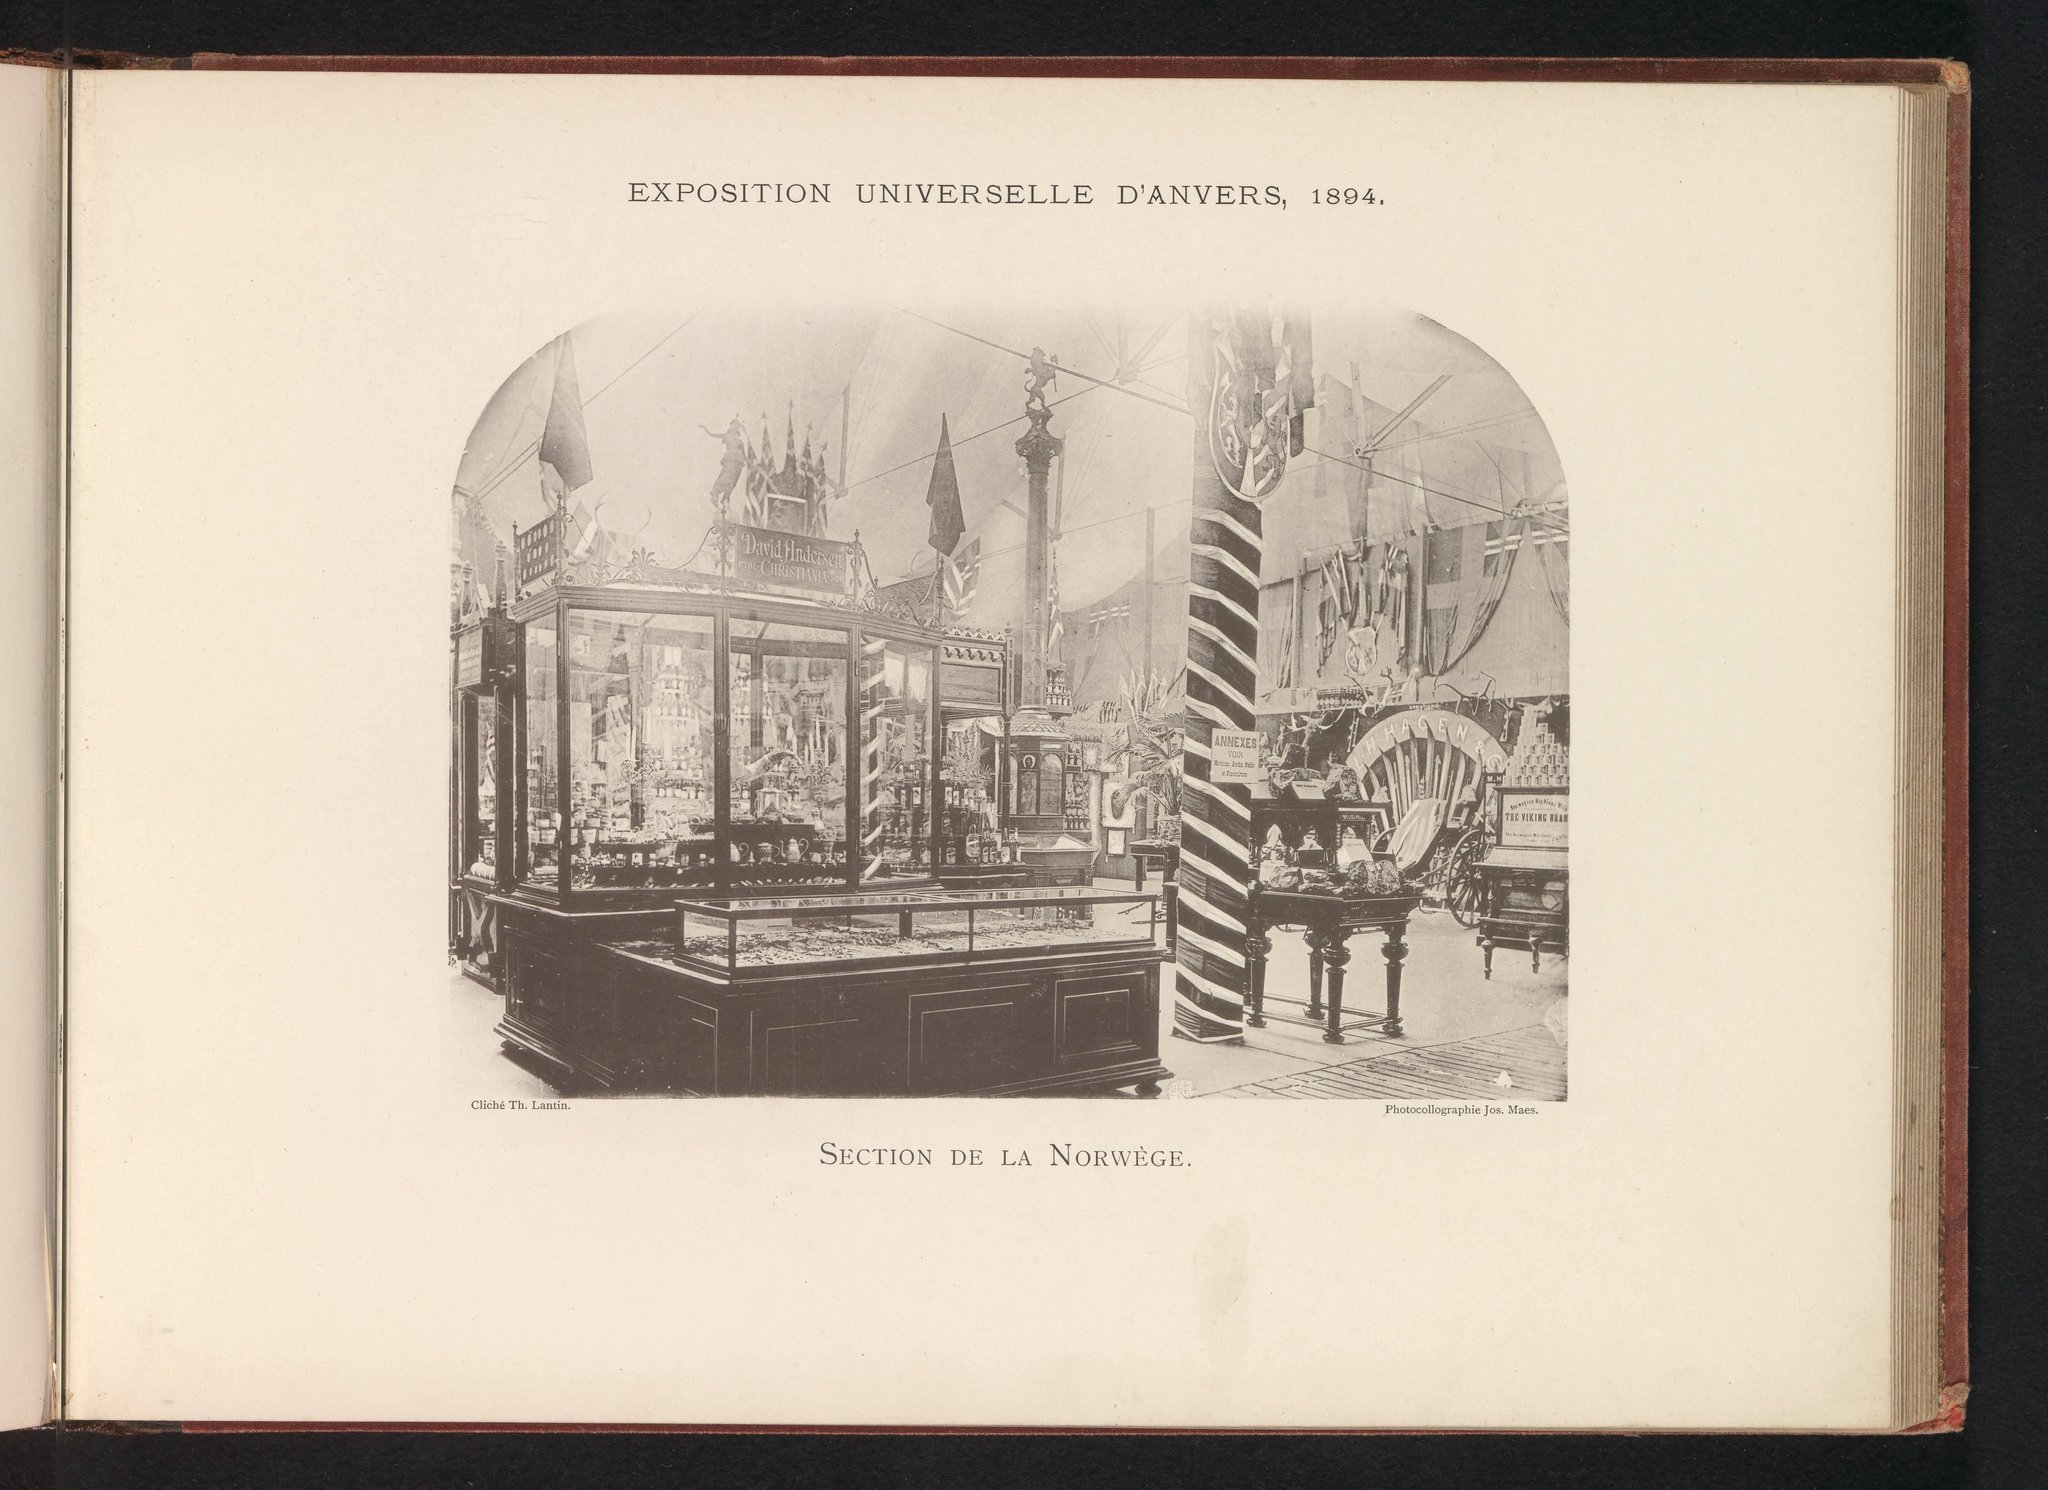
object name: page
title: Expositie van Noorse objecten tijdens de wereldtentoonstelling te Antwerpen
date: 1894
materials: paper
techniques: photograph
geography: antwerp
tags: world fair, world exhibition, collection, exhibition, show